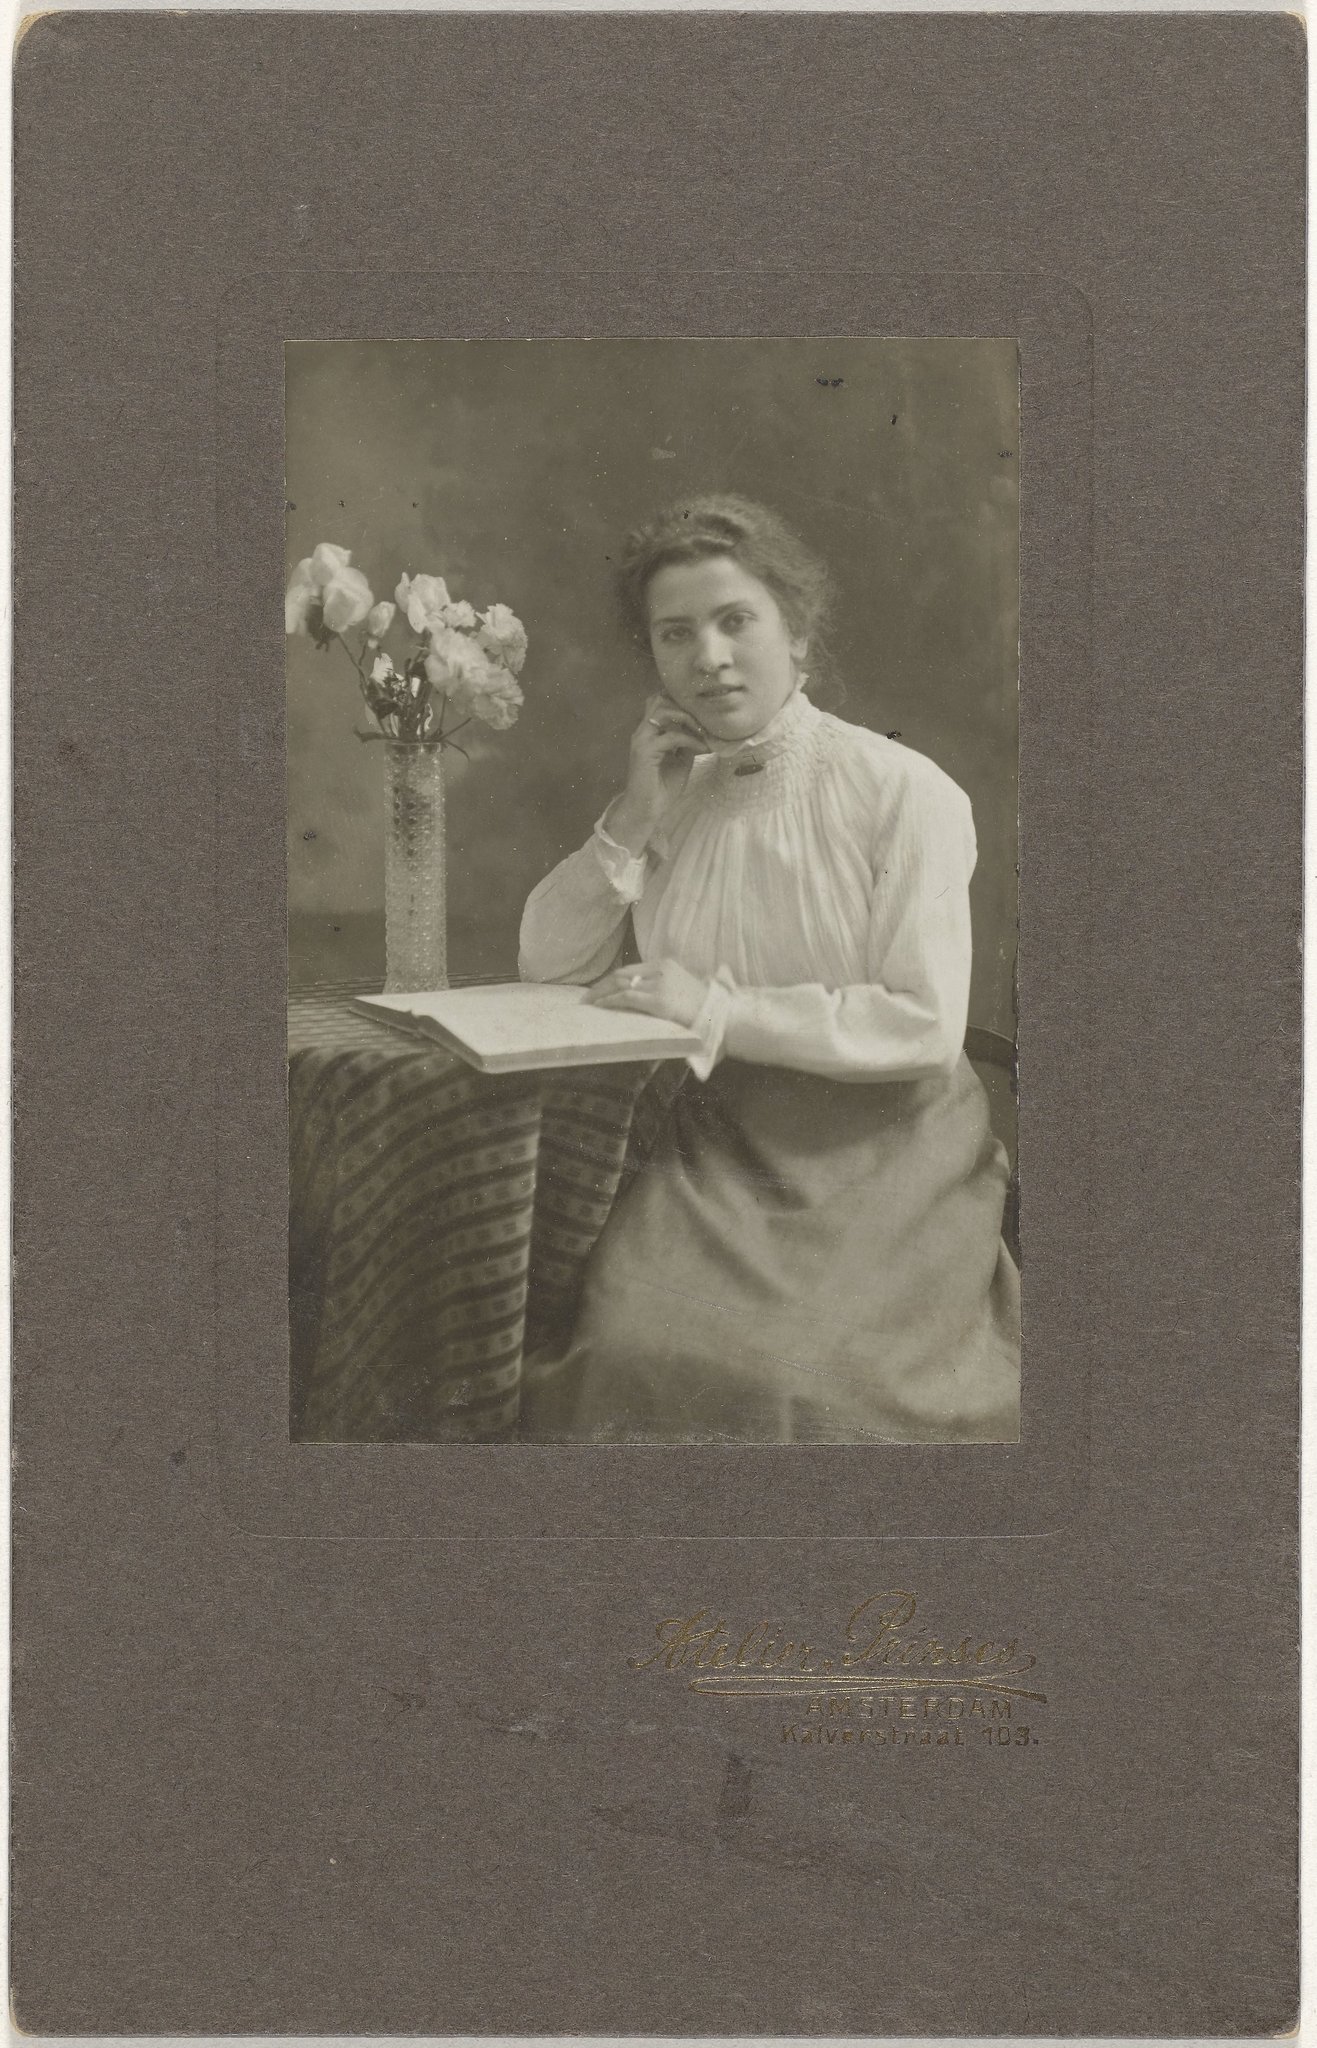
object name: photograph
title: Studioportret van een zittende vrouw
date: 1890-1920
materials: cardboard, photographic support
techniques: collodion silver print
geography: amsterdam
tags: amsterdam